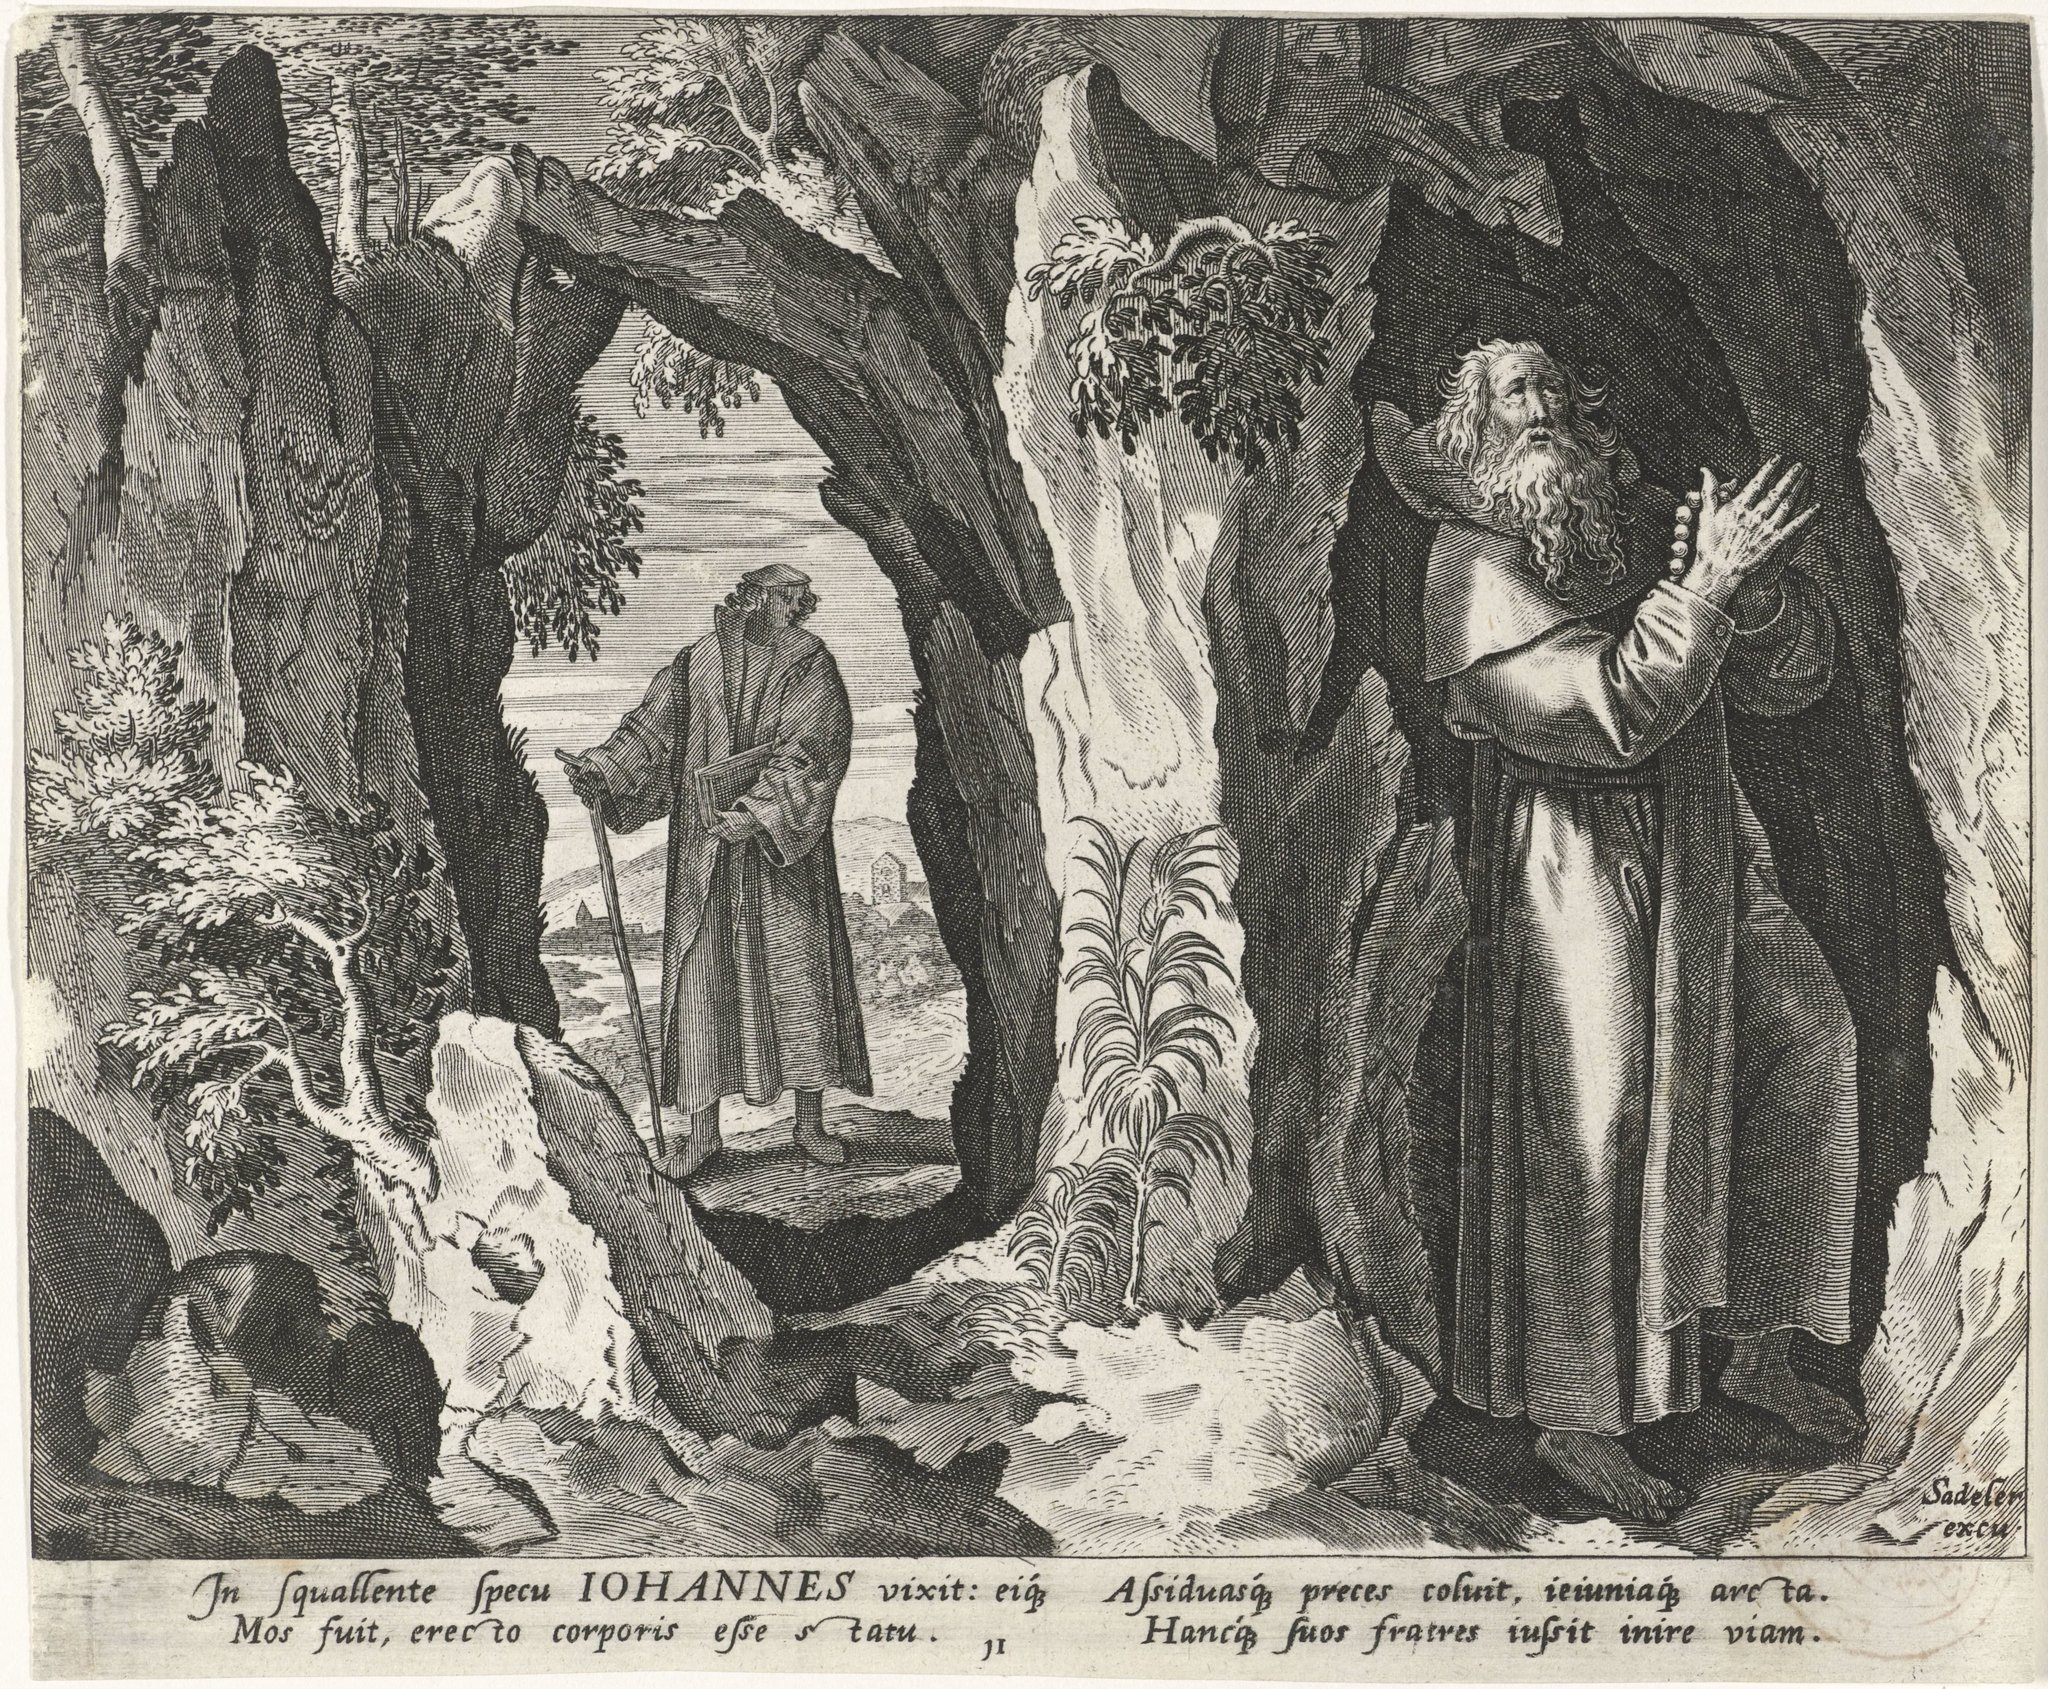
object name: print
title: Johannes de kluizenaar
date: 1583-1588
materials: paper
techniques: engraving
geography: antwerp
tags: wandering scholar, the apostle john the evangelist; possible attributes: book, cauldron, chalice with snake, eagle, palm, scroll, anchorite, hermit, cave, grotto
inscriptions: collector's mark: Lugt 240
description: Johannes de kluizenaar in een grot in de woestijn. Hij bidt de rozenkrans. Op de achtergrond staat een geleerde voor de ingang van de grot.